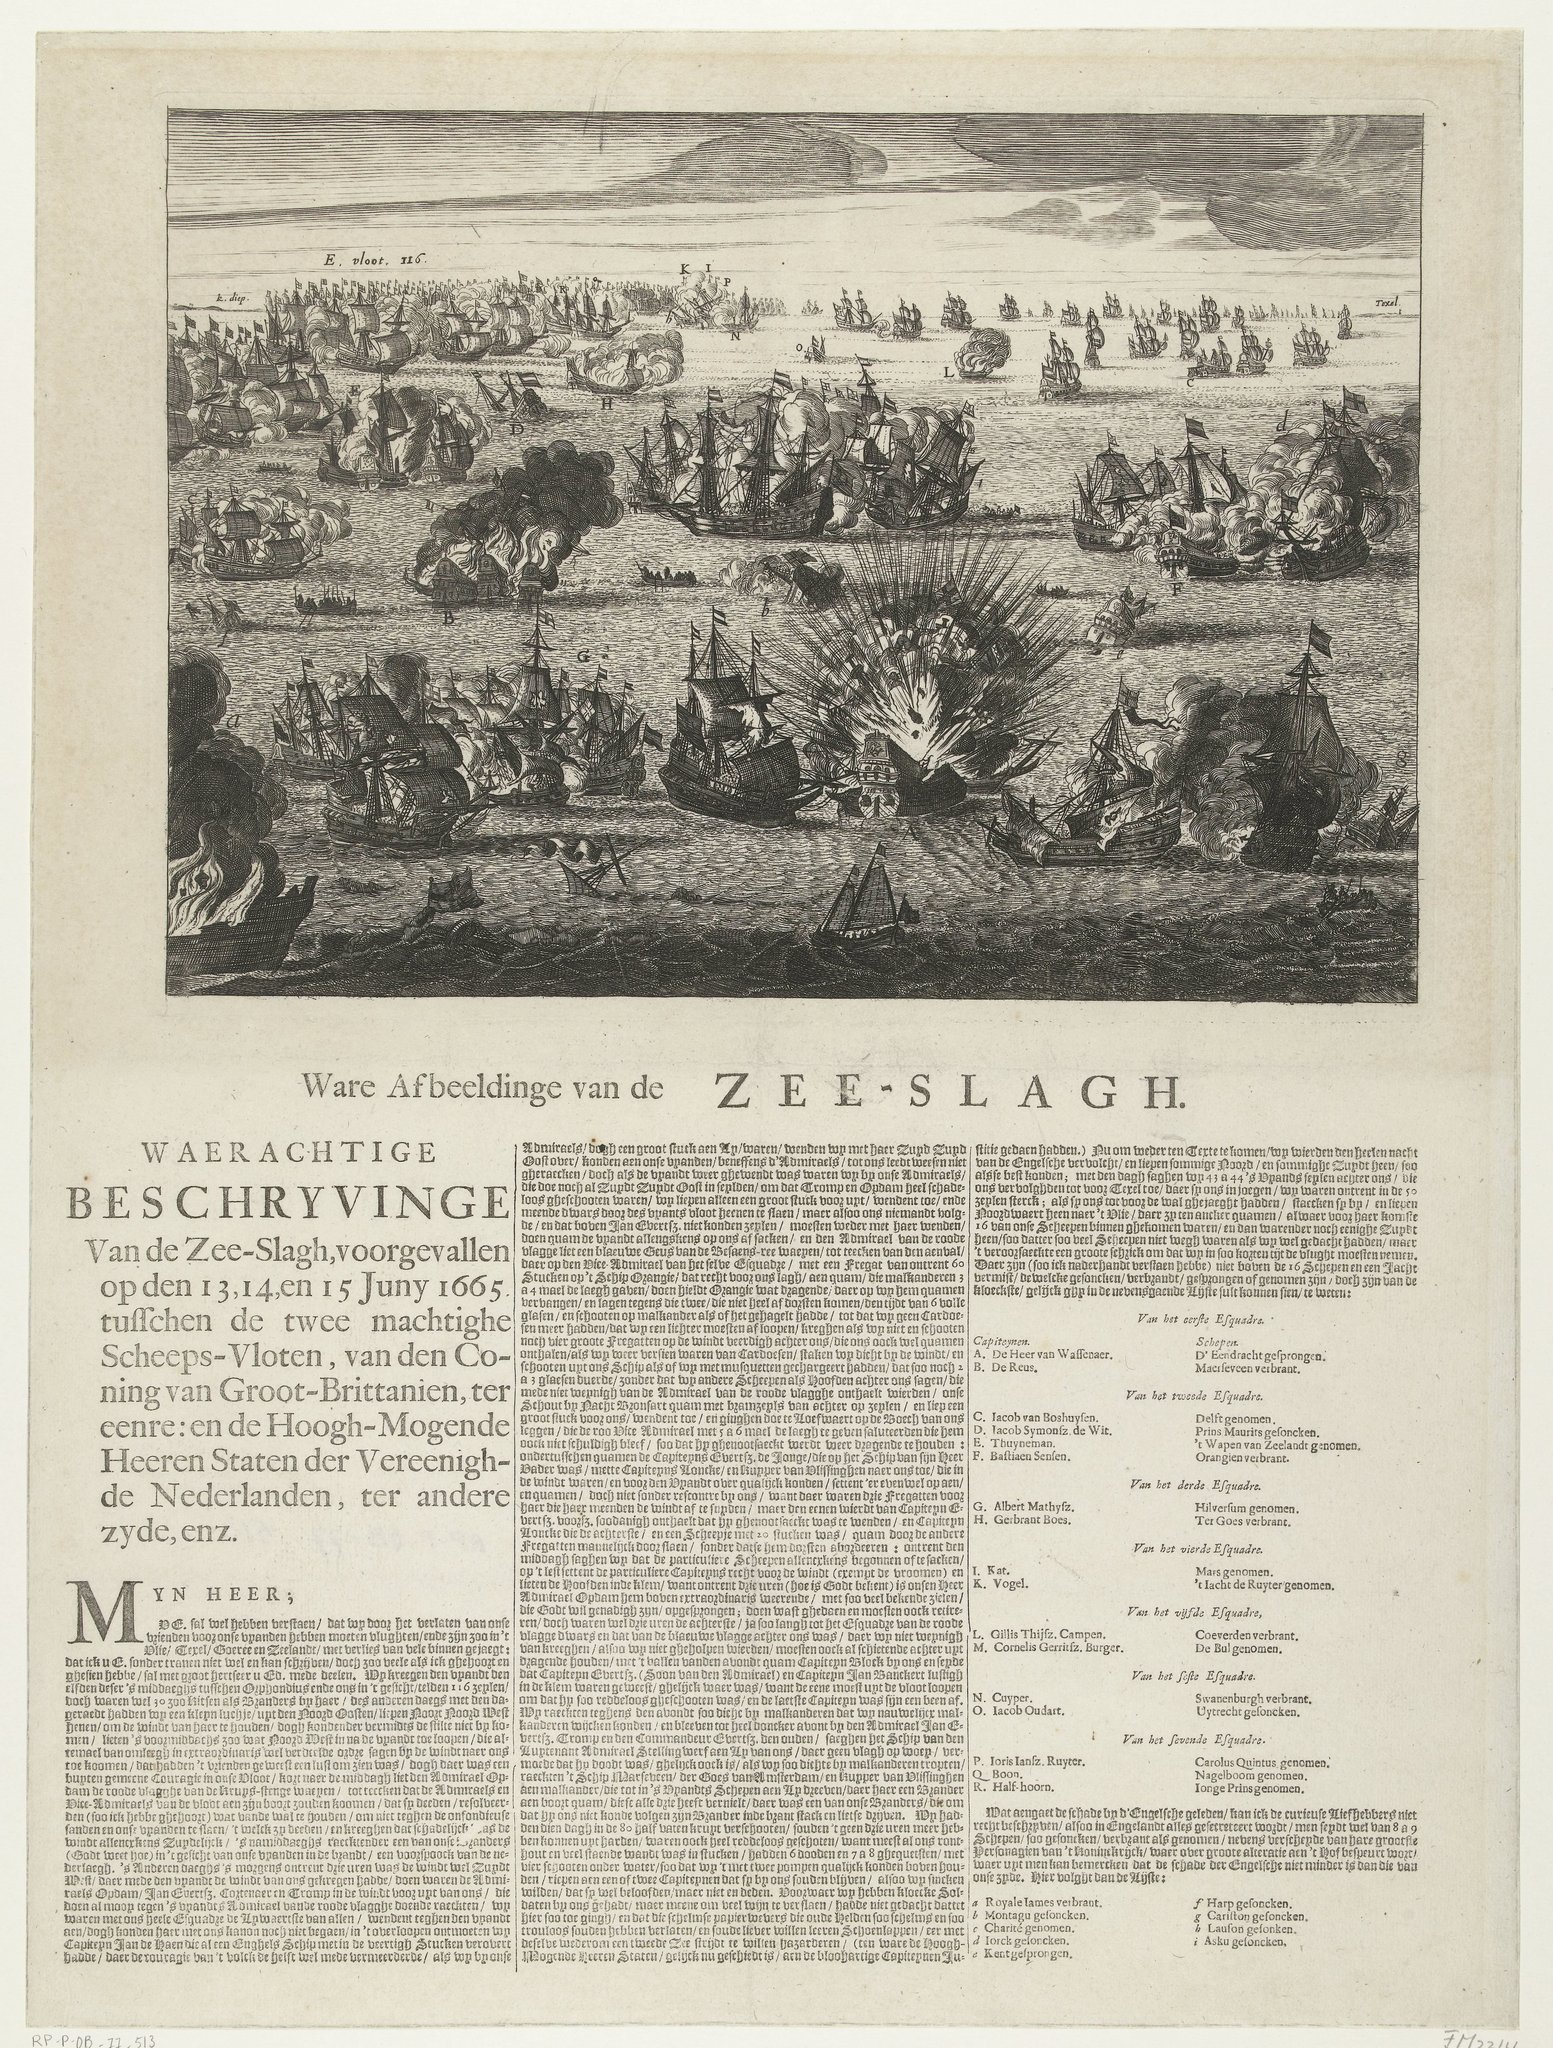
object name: print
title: Zeegevecht voor Lowestoft tussen de Engelsen en de Nederlanders onder Wassenaar van Obdam, 1665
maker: Anonymous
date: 1665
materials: paper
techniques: engraving, etching, letterpress printing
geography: northern netherlands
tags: james stuart (hertog van york), jacob baron van wassenaer heer van obdam, battle (+ naval force), battle of lowestoft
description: Zeegevecht voor Lowestoft (Lestoffe) tussen de Engelsen onder de hertog van York en de Nederlanders onder Wassenaer van Obdam, wiens schip met 500 man in de lucht vliegt. De overlevenden vluchten en de Engelsen behalen de overwinning. (13-15 juni 1665). Bovenaan links de Engelse vloot, rechts in de verte Texel. Onder de plaat op het blad gedrukt een beschrijving van de zeeslag in 3 kolommen.